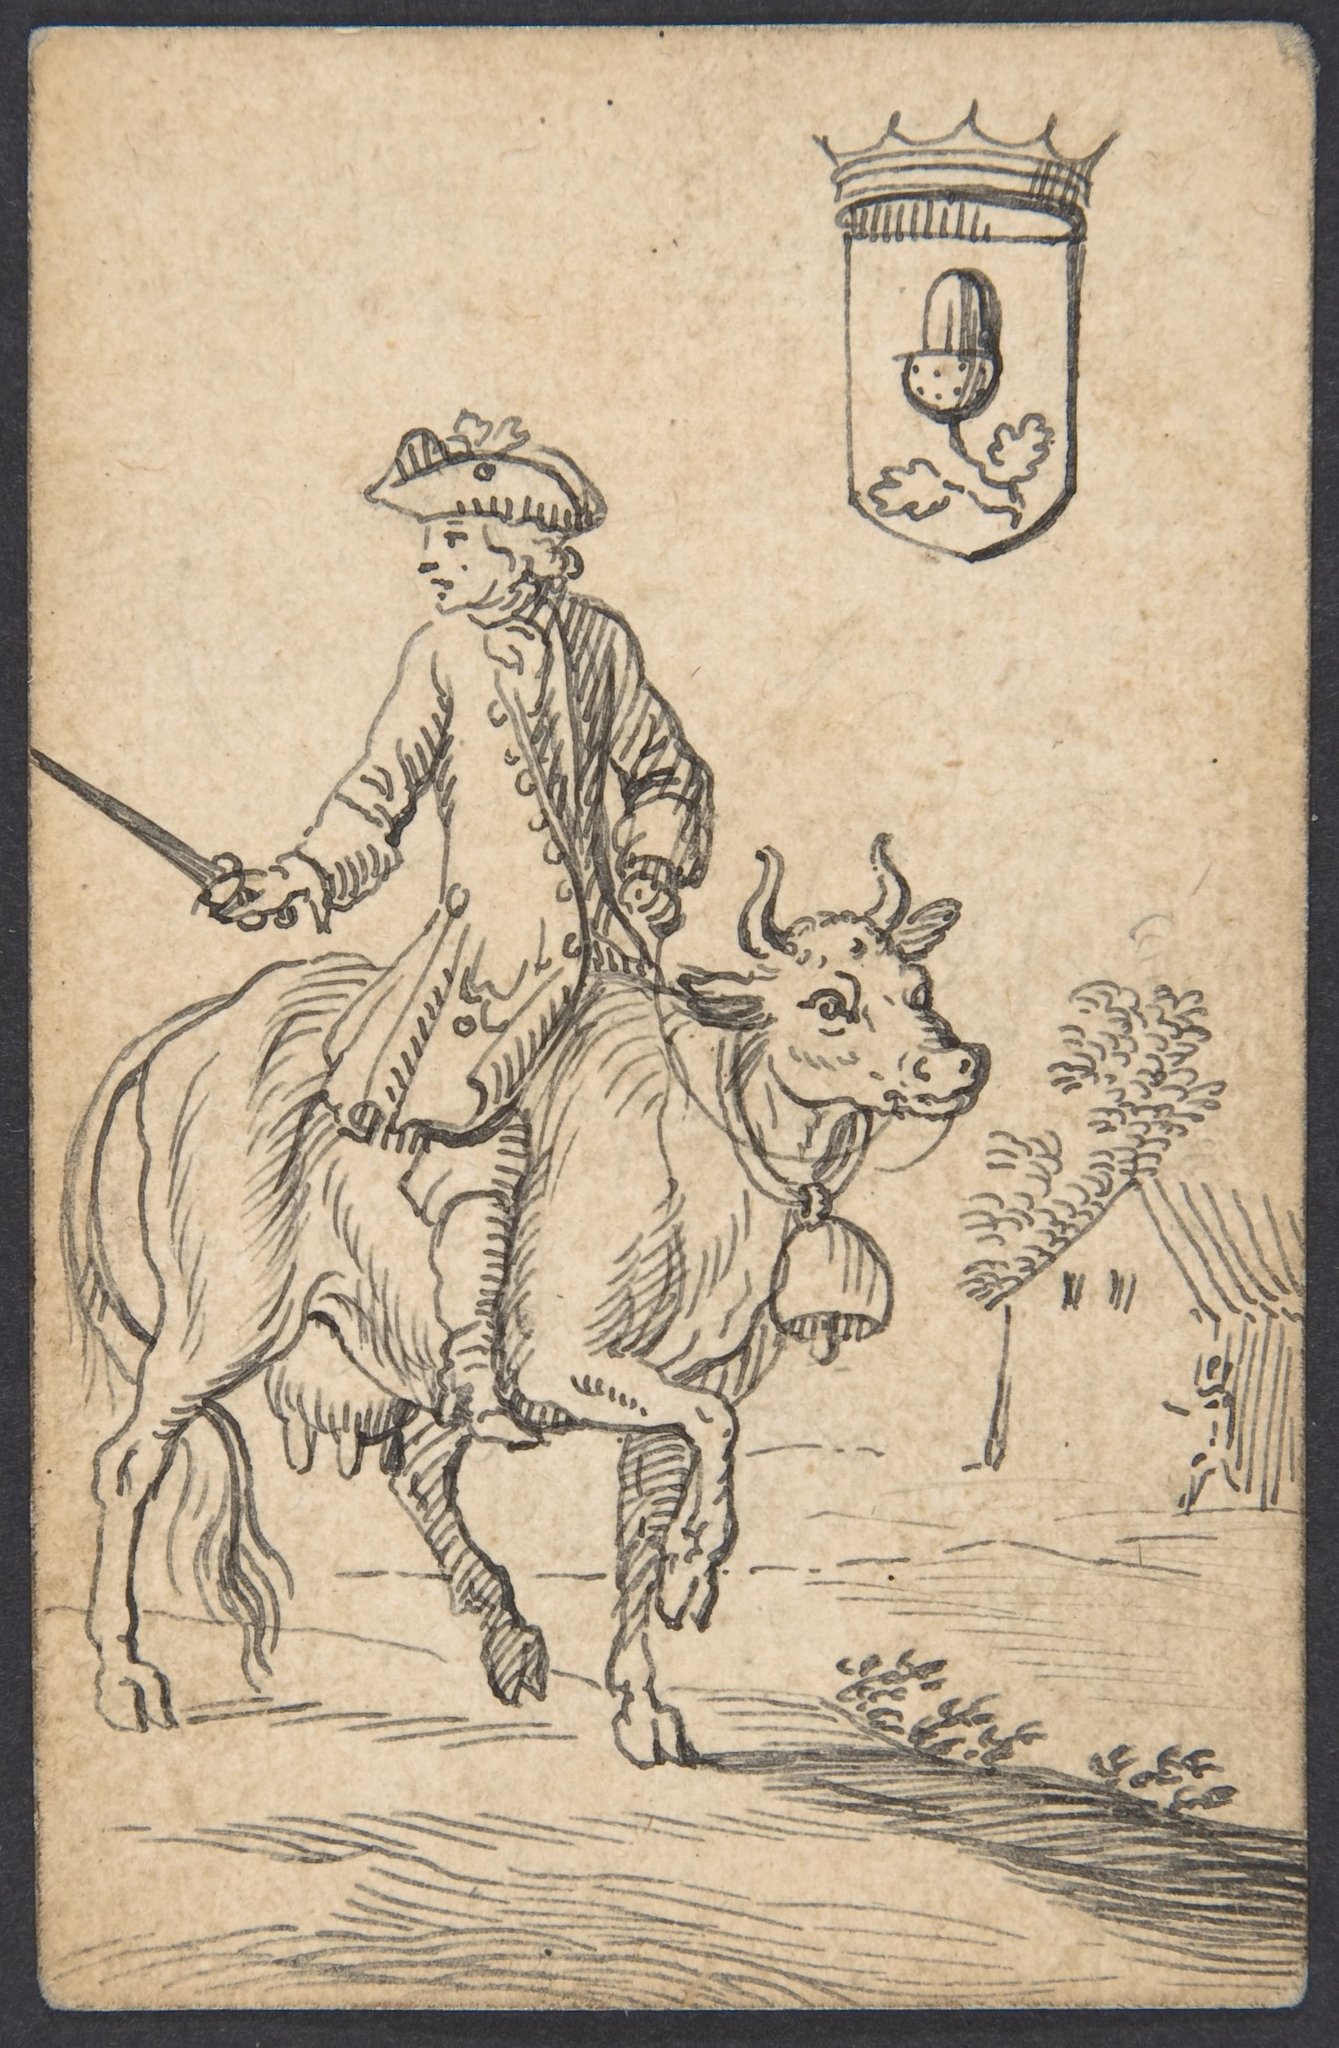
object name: drawing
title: Acorn King: A Man Astride a Cow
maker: johannes brandenberg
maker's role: artist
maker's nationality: swiss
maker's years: 1661-1729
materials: ink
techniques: pen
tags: men,cows